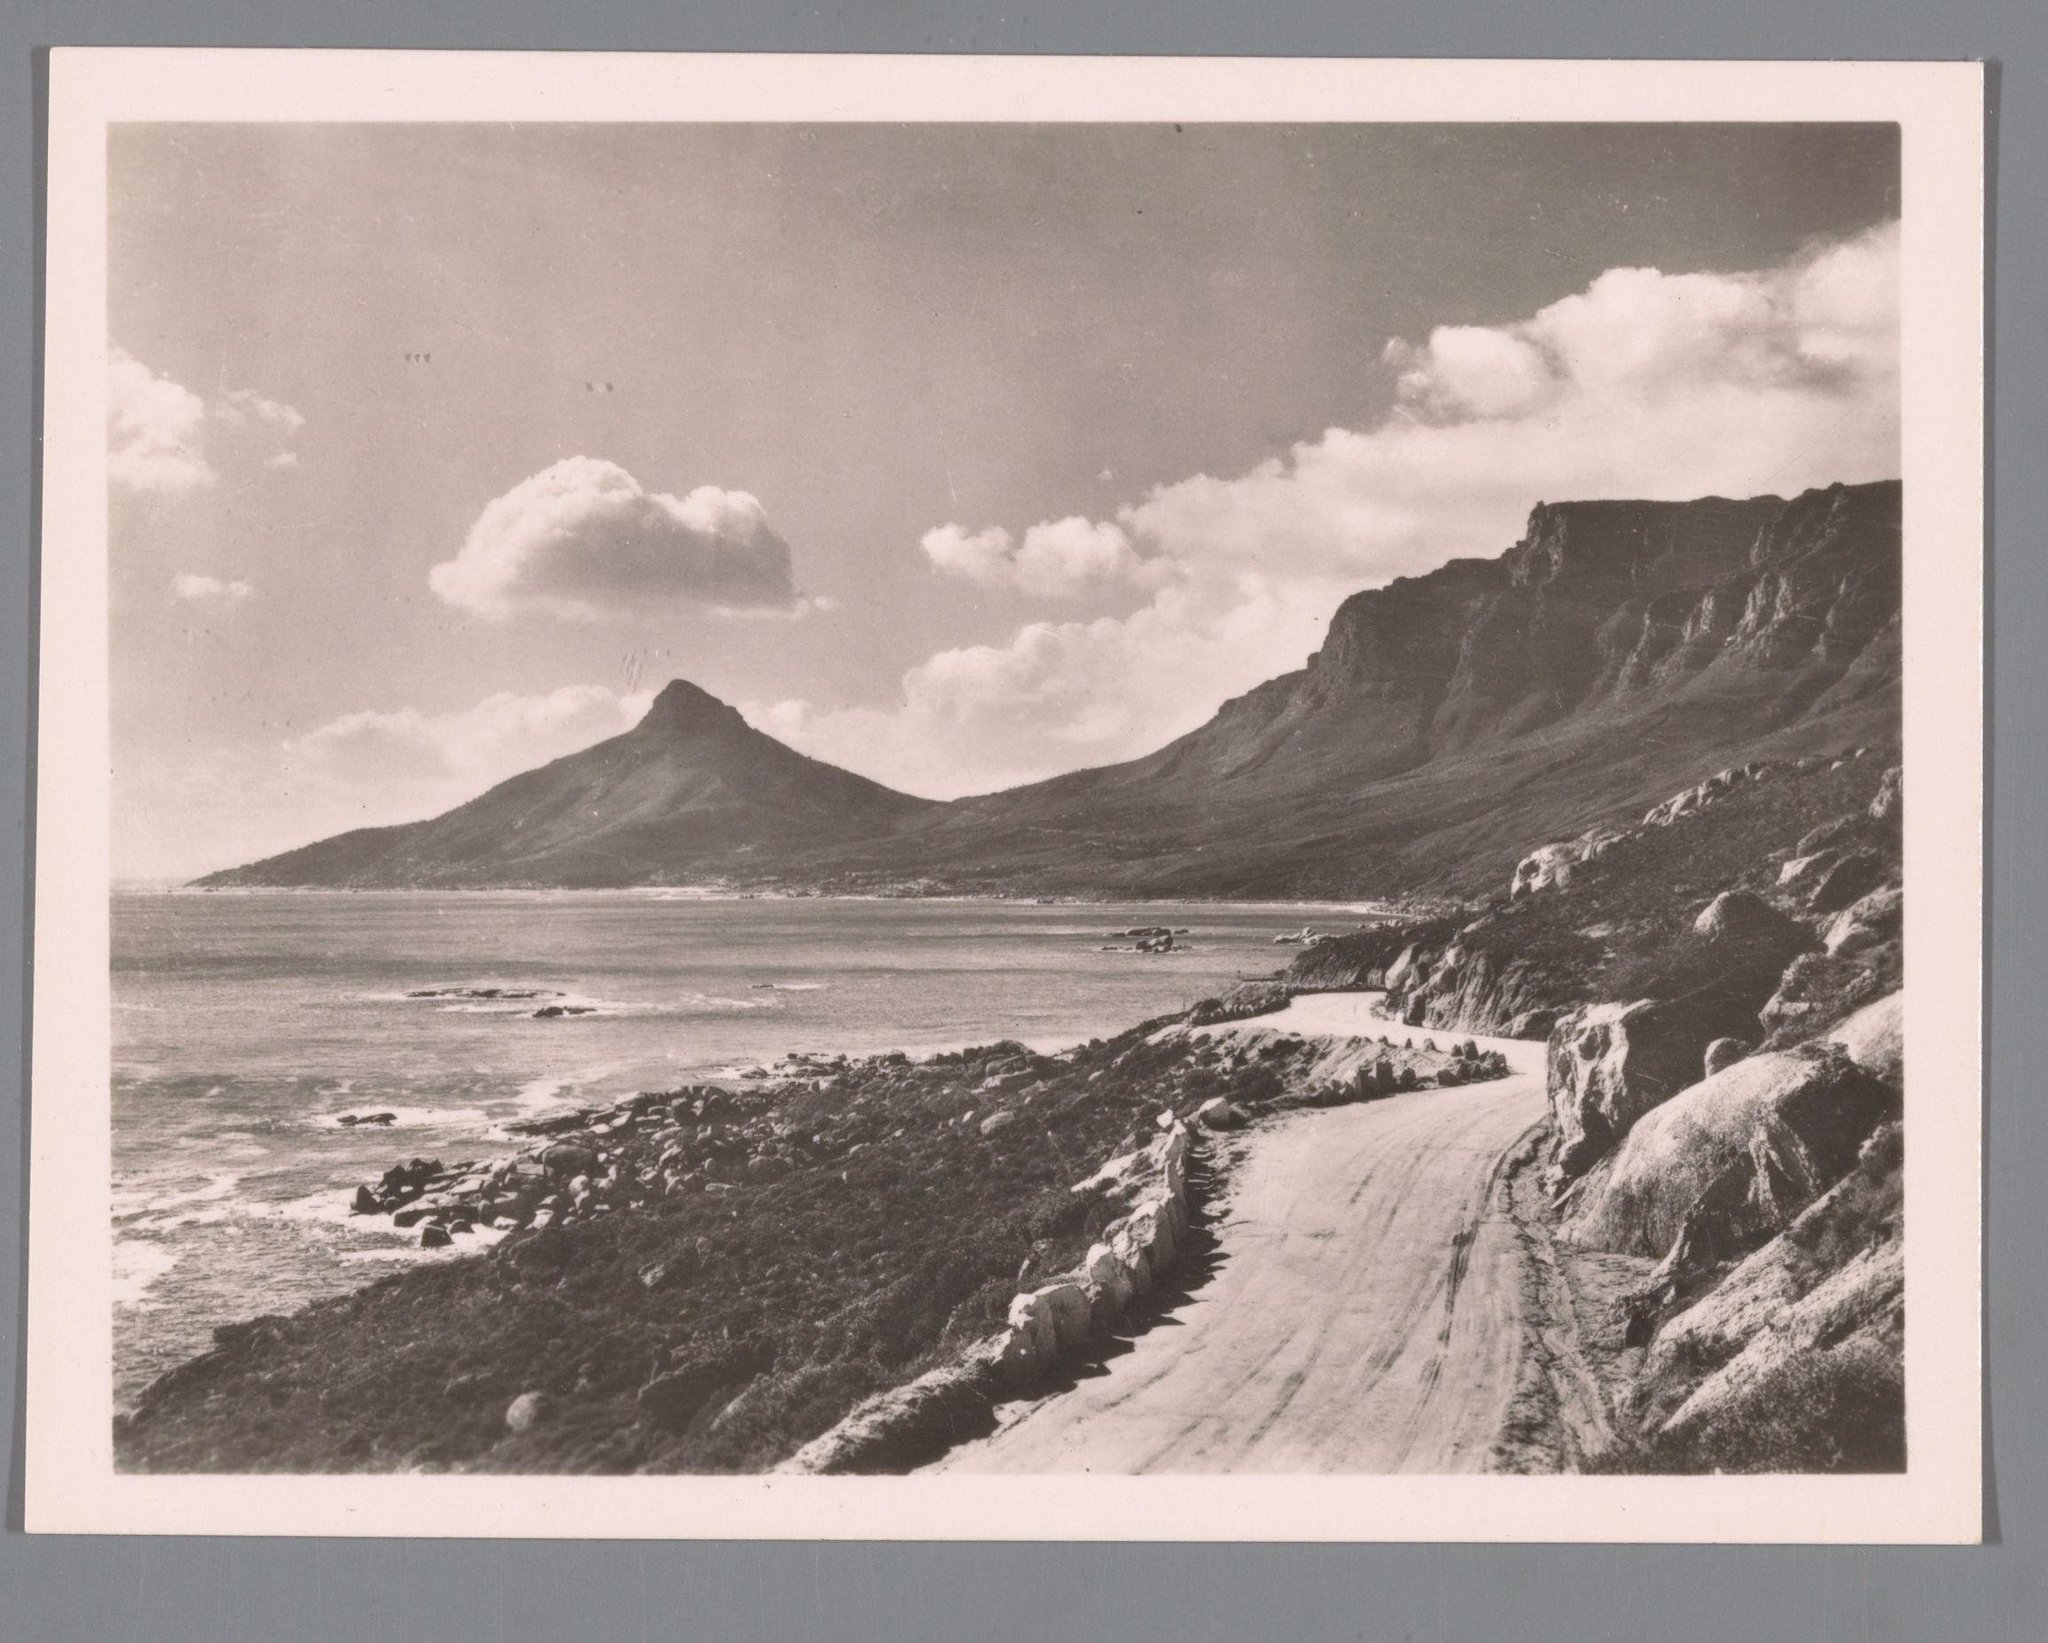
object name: photograph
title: Gezicht op de Tafelberg en de Leeukop in Kaapstad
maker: blackshaw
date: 1940-1960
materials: photographic support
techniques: gelatin silver print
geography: south africa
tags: mountains